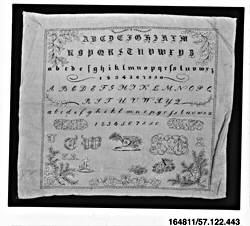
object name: sampler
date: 1801-1900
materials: cotton, linen